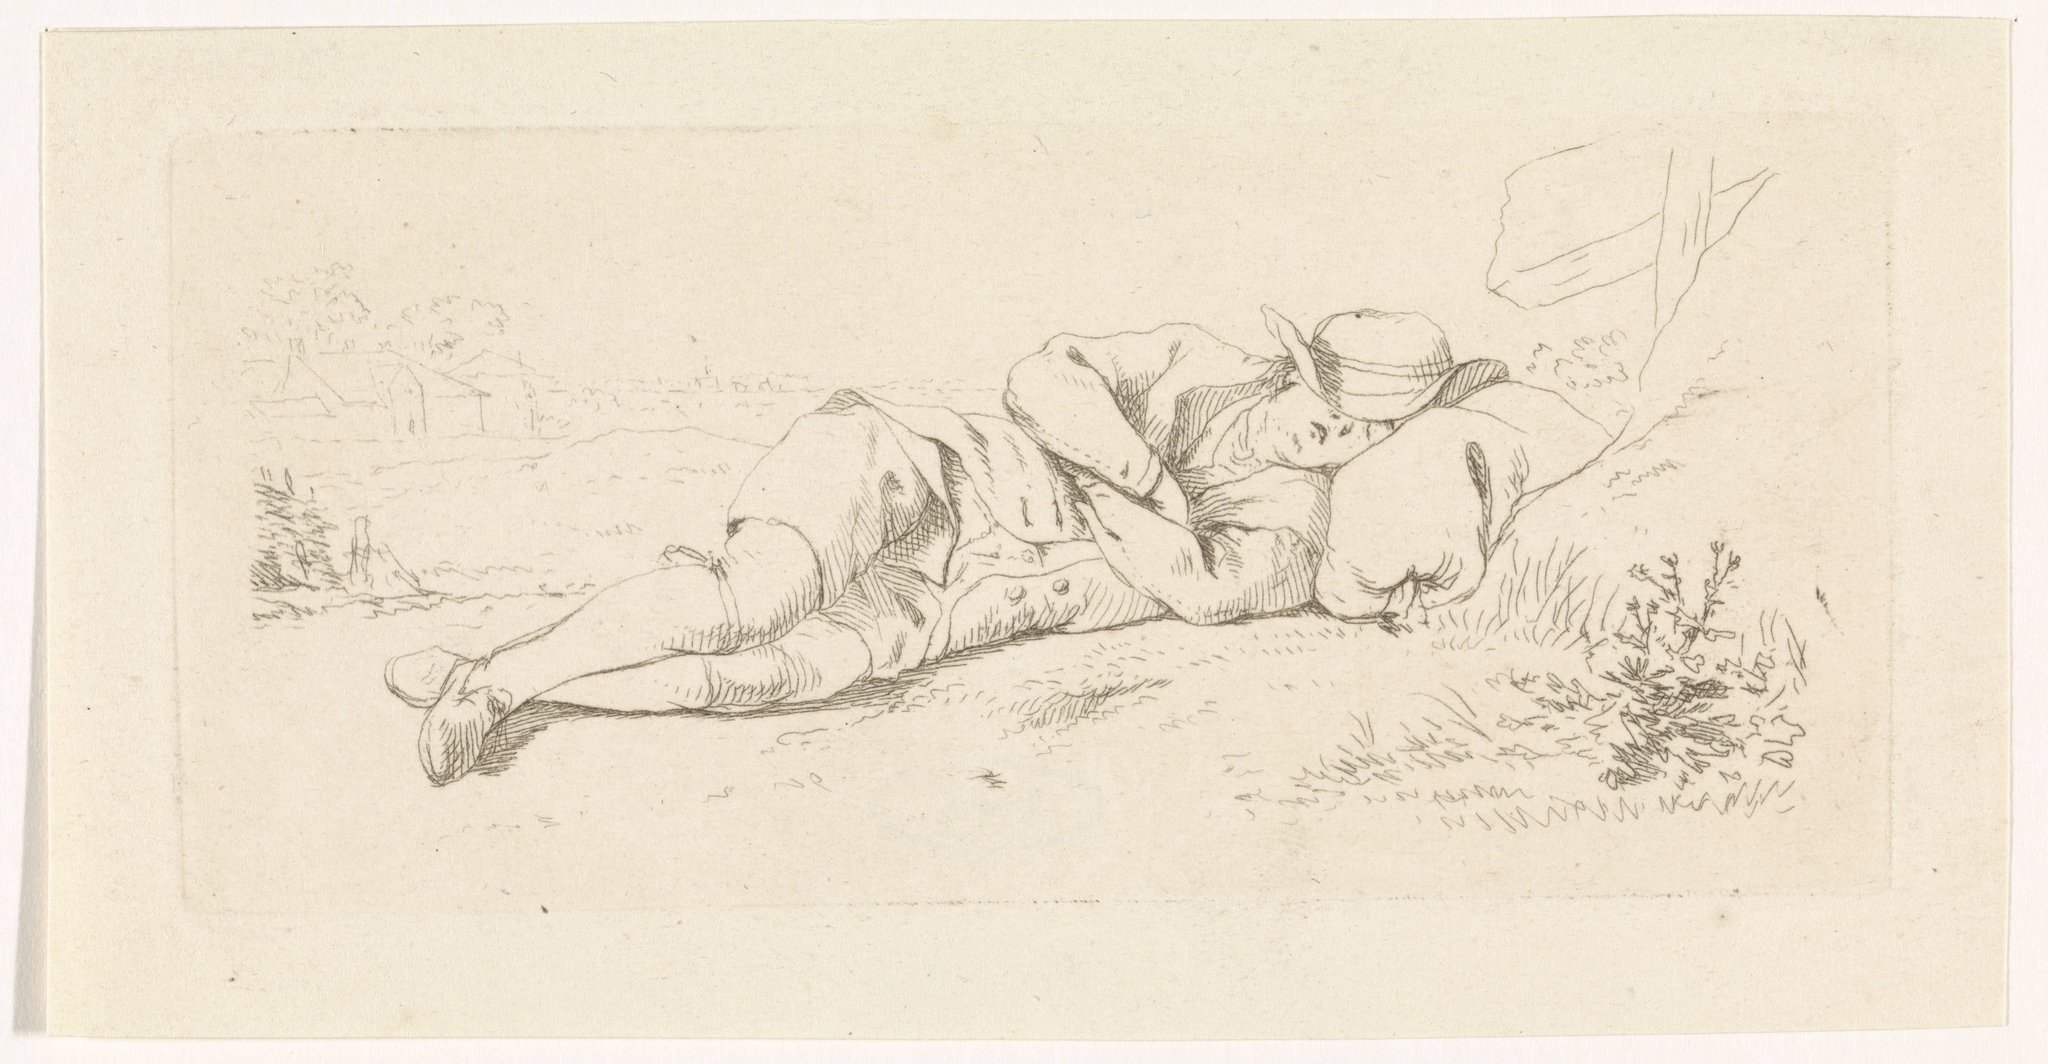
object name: print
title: Slapende jongeman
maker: pieter de goeje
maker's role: draughtsman, print maker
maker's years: 1789-1859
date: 1789-1859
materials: paper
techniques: etching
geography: amsterdam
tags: sleeping; unconsciousness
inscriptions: collector's mark: Lugt 2228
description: Een man ligt te slapen aan de kant van een weg. Hij rust zijn hoofd op een zak.